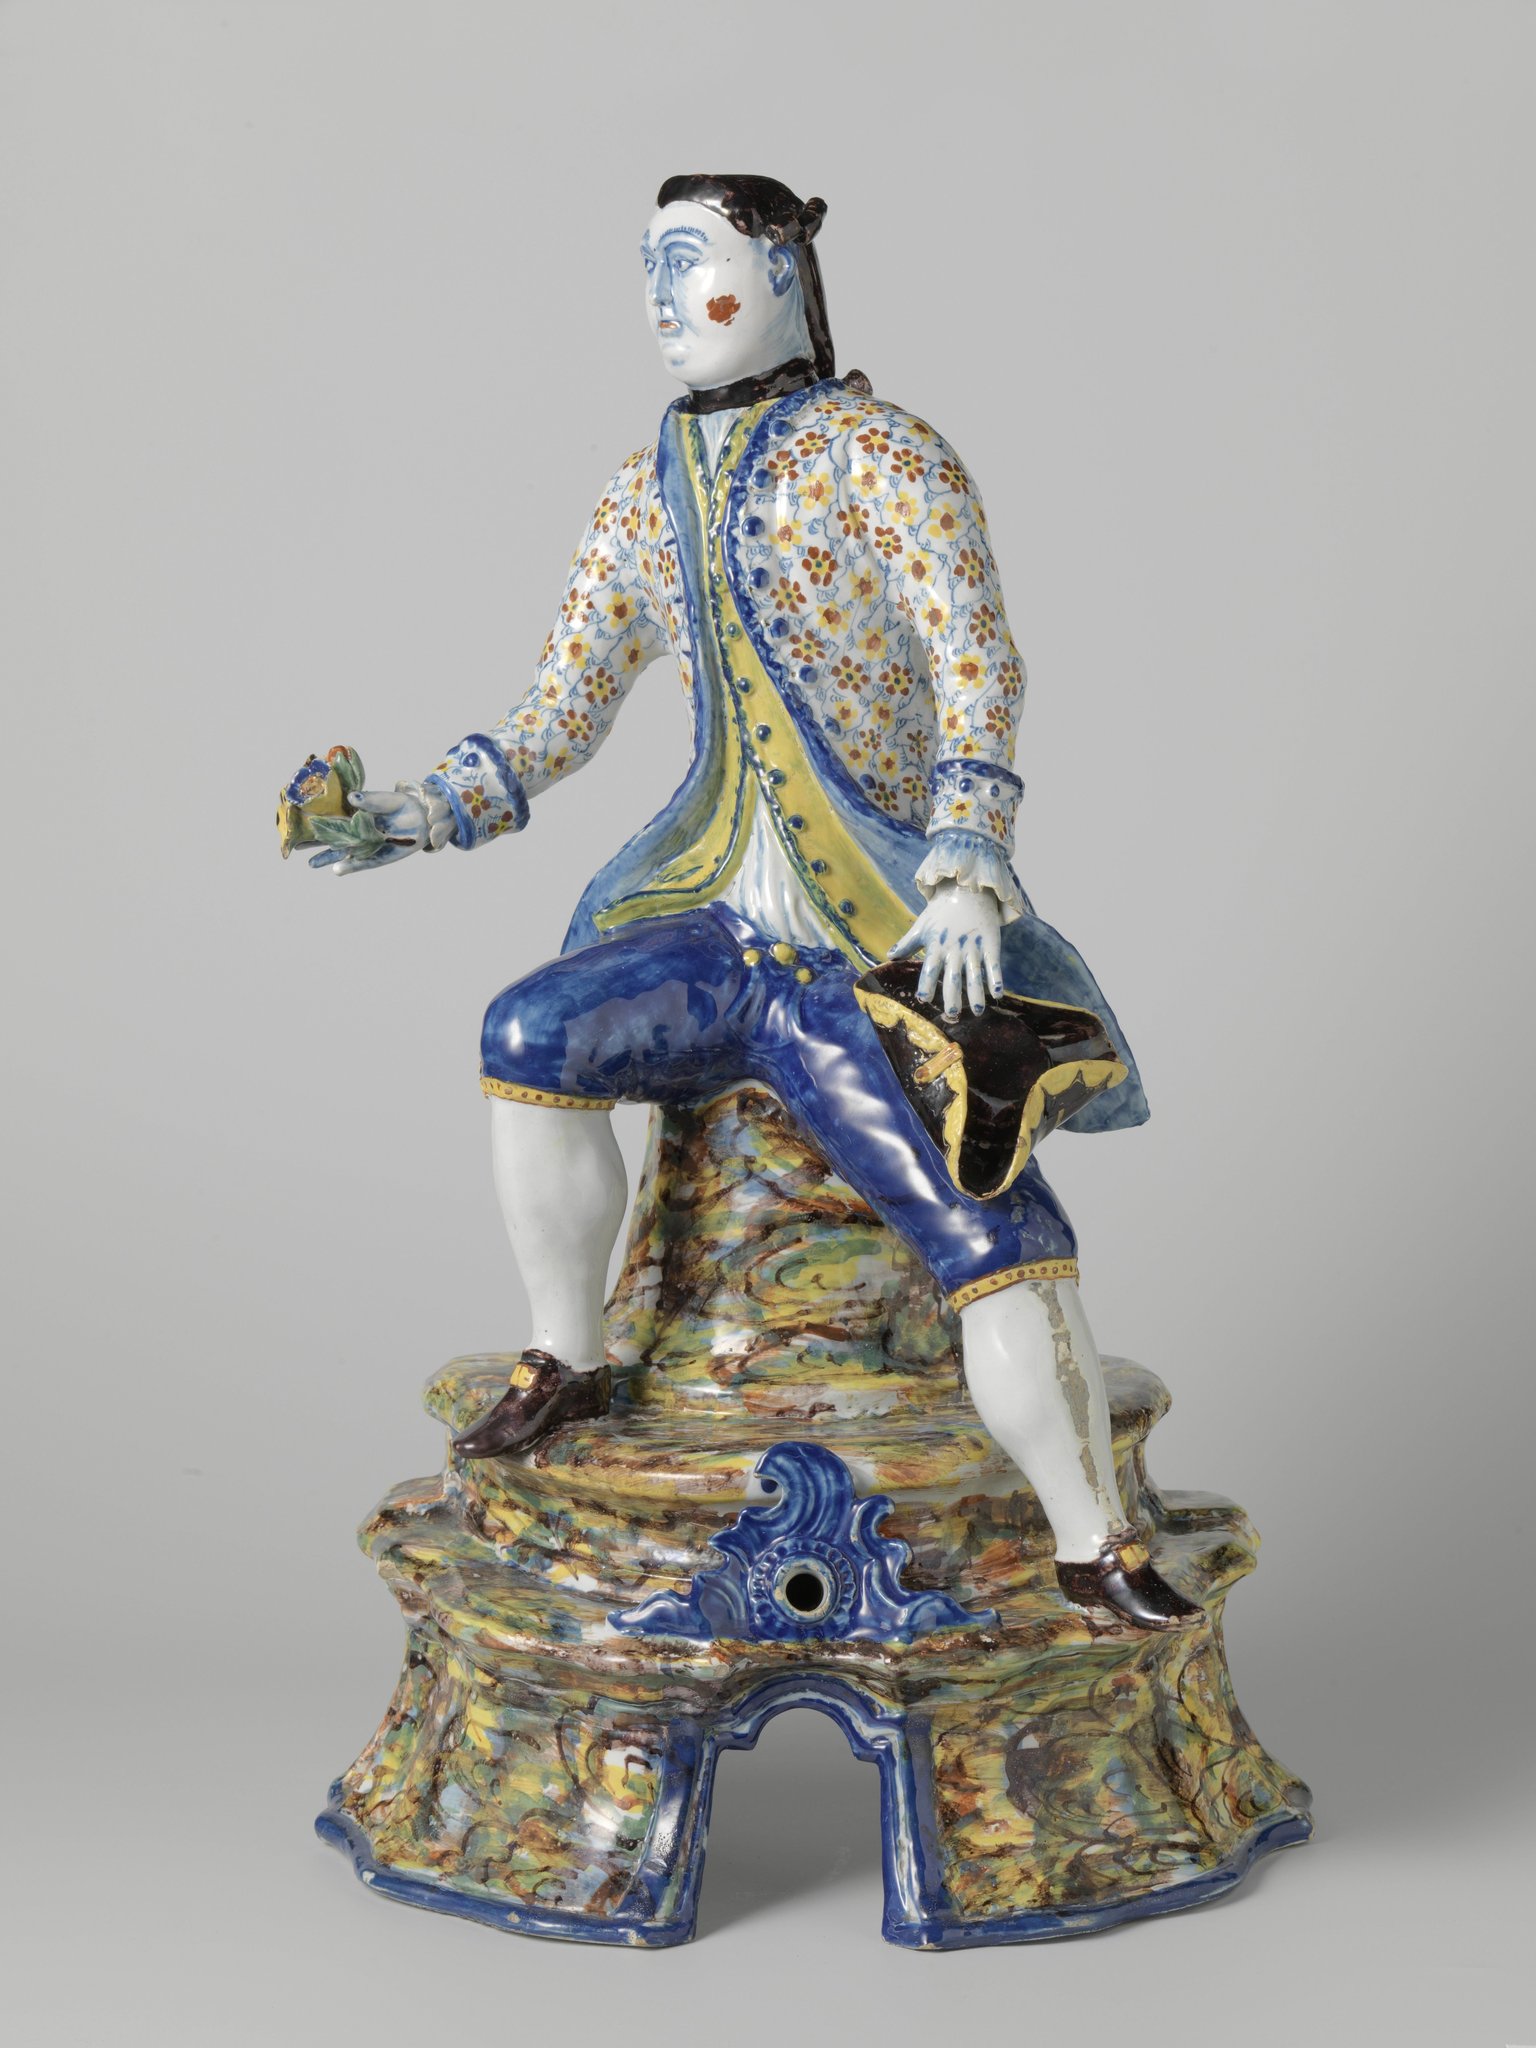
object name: decoratief object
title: Deksel van fontein in de vorm van een hoofd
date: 1760-1775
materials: earthenware, glaze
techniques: painted, polychromy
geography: delft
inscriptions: mark: ‘figuratief teken klauw’, collector's mark: ‘collection JF Loudon’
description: Deksel van fontein in de vorm van een hoofd van veelkleurig beschilderde faïence.